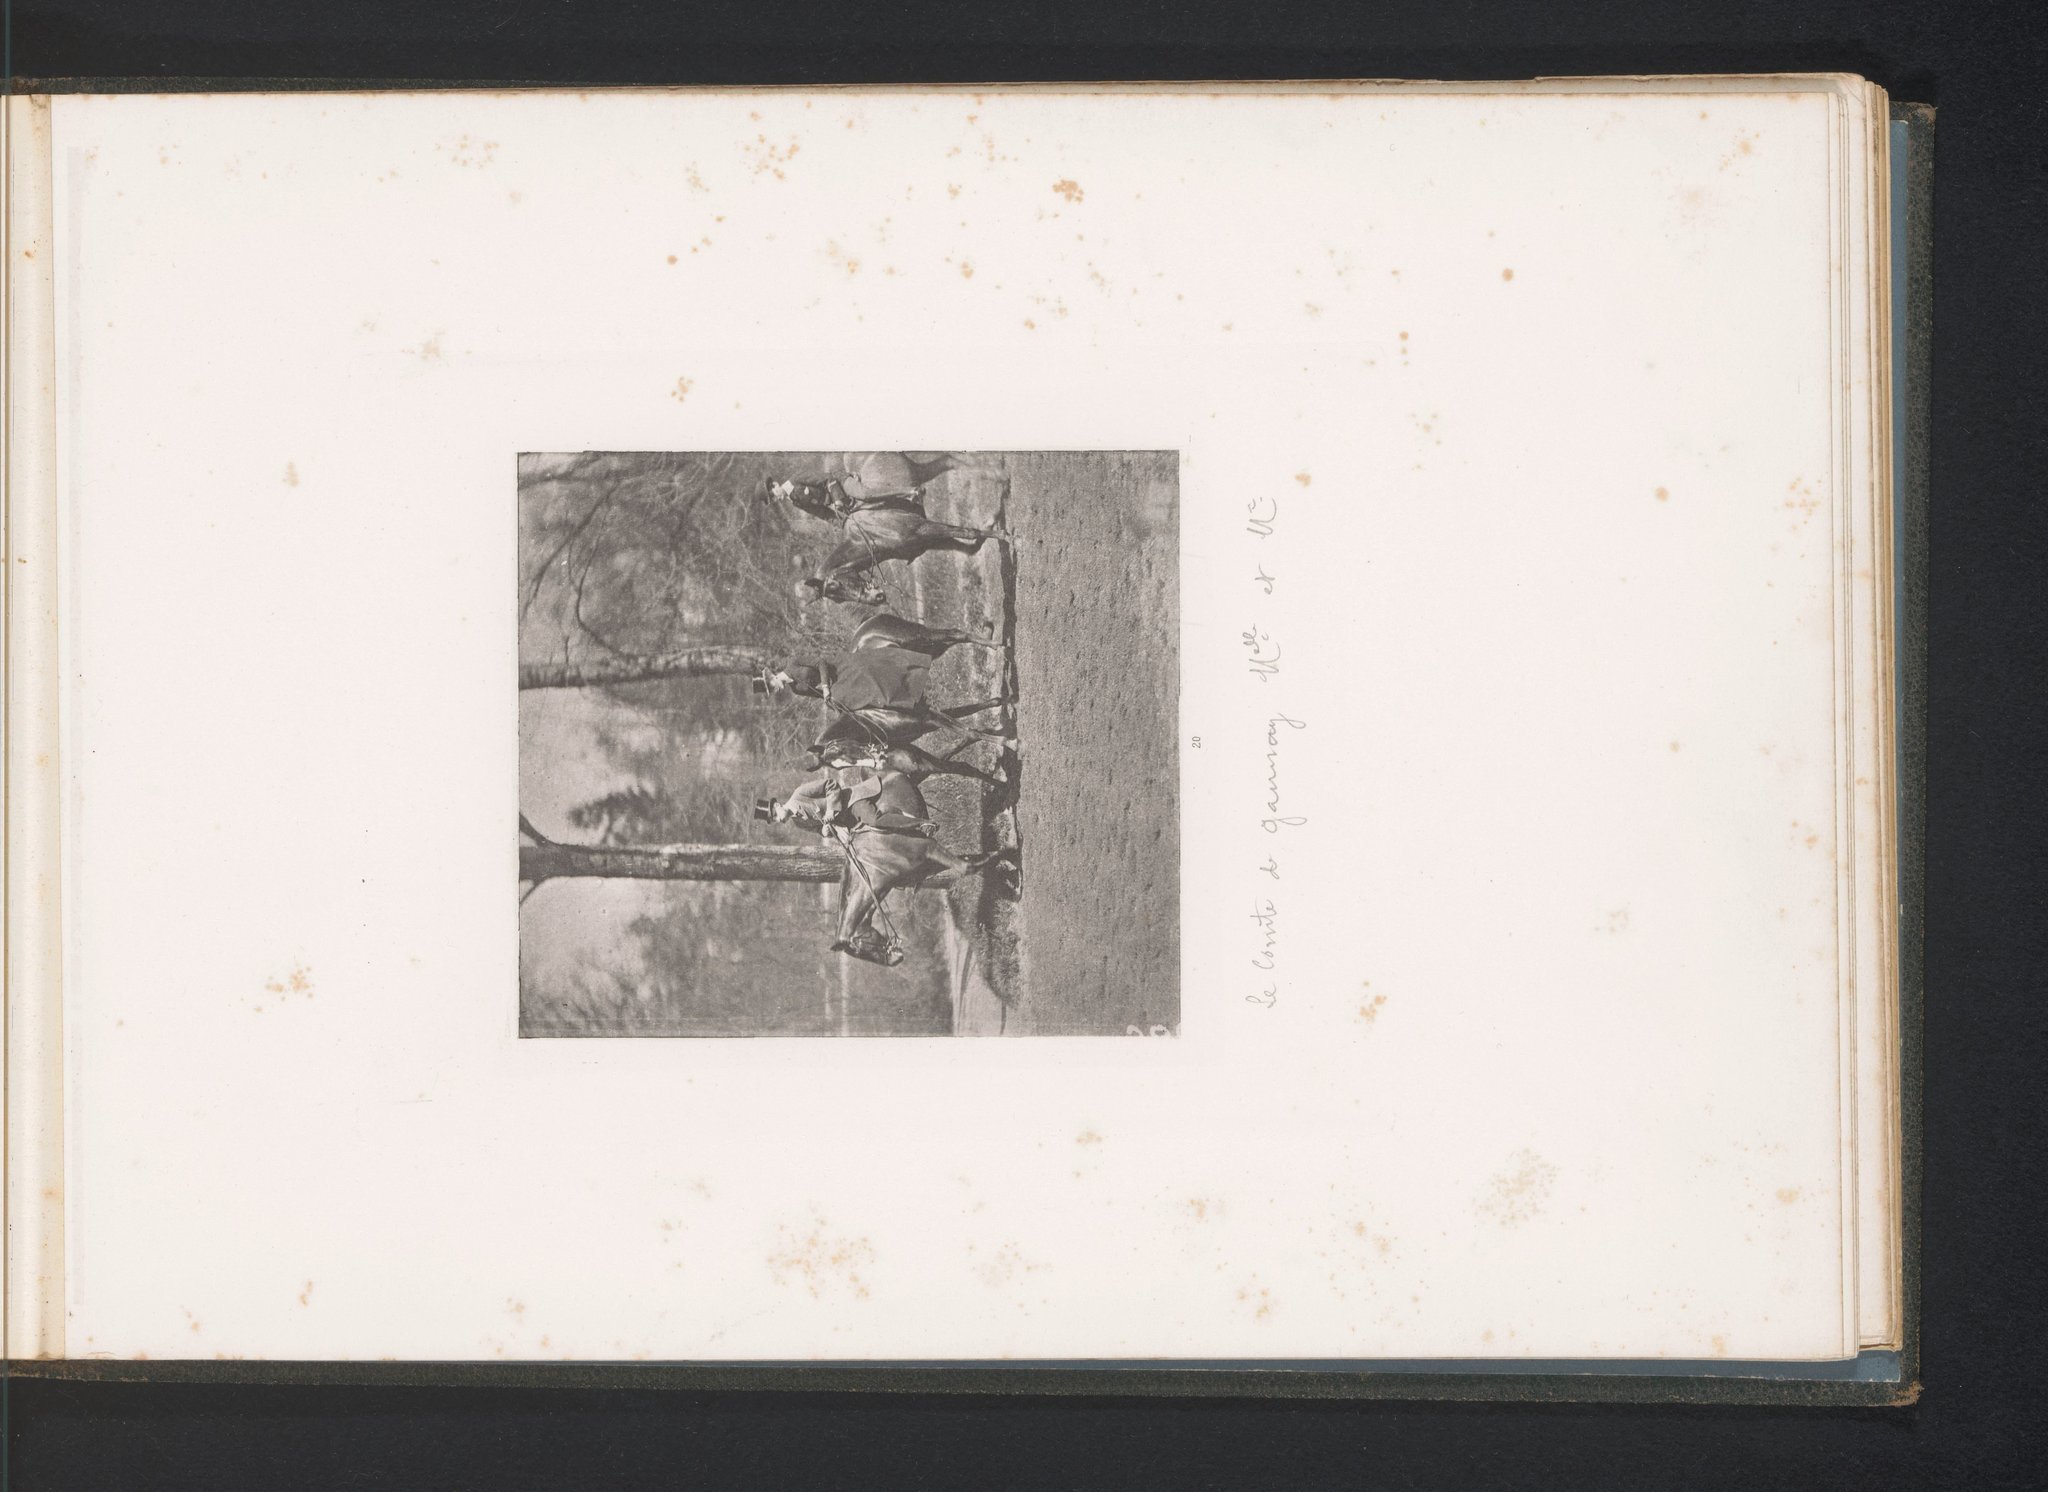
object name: photomechanical print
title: Drie ruiters te paard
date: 1874-1884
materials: paper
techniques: photoaquatint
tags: riding a horse, ass, or mule; rider, horseman, head-gear: top hat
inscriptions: number: ‘20’, inscription: ‘le Comte de Ganay Mlle et M.’